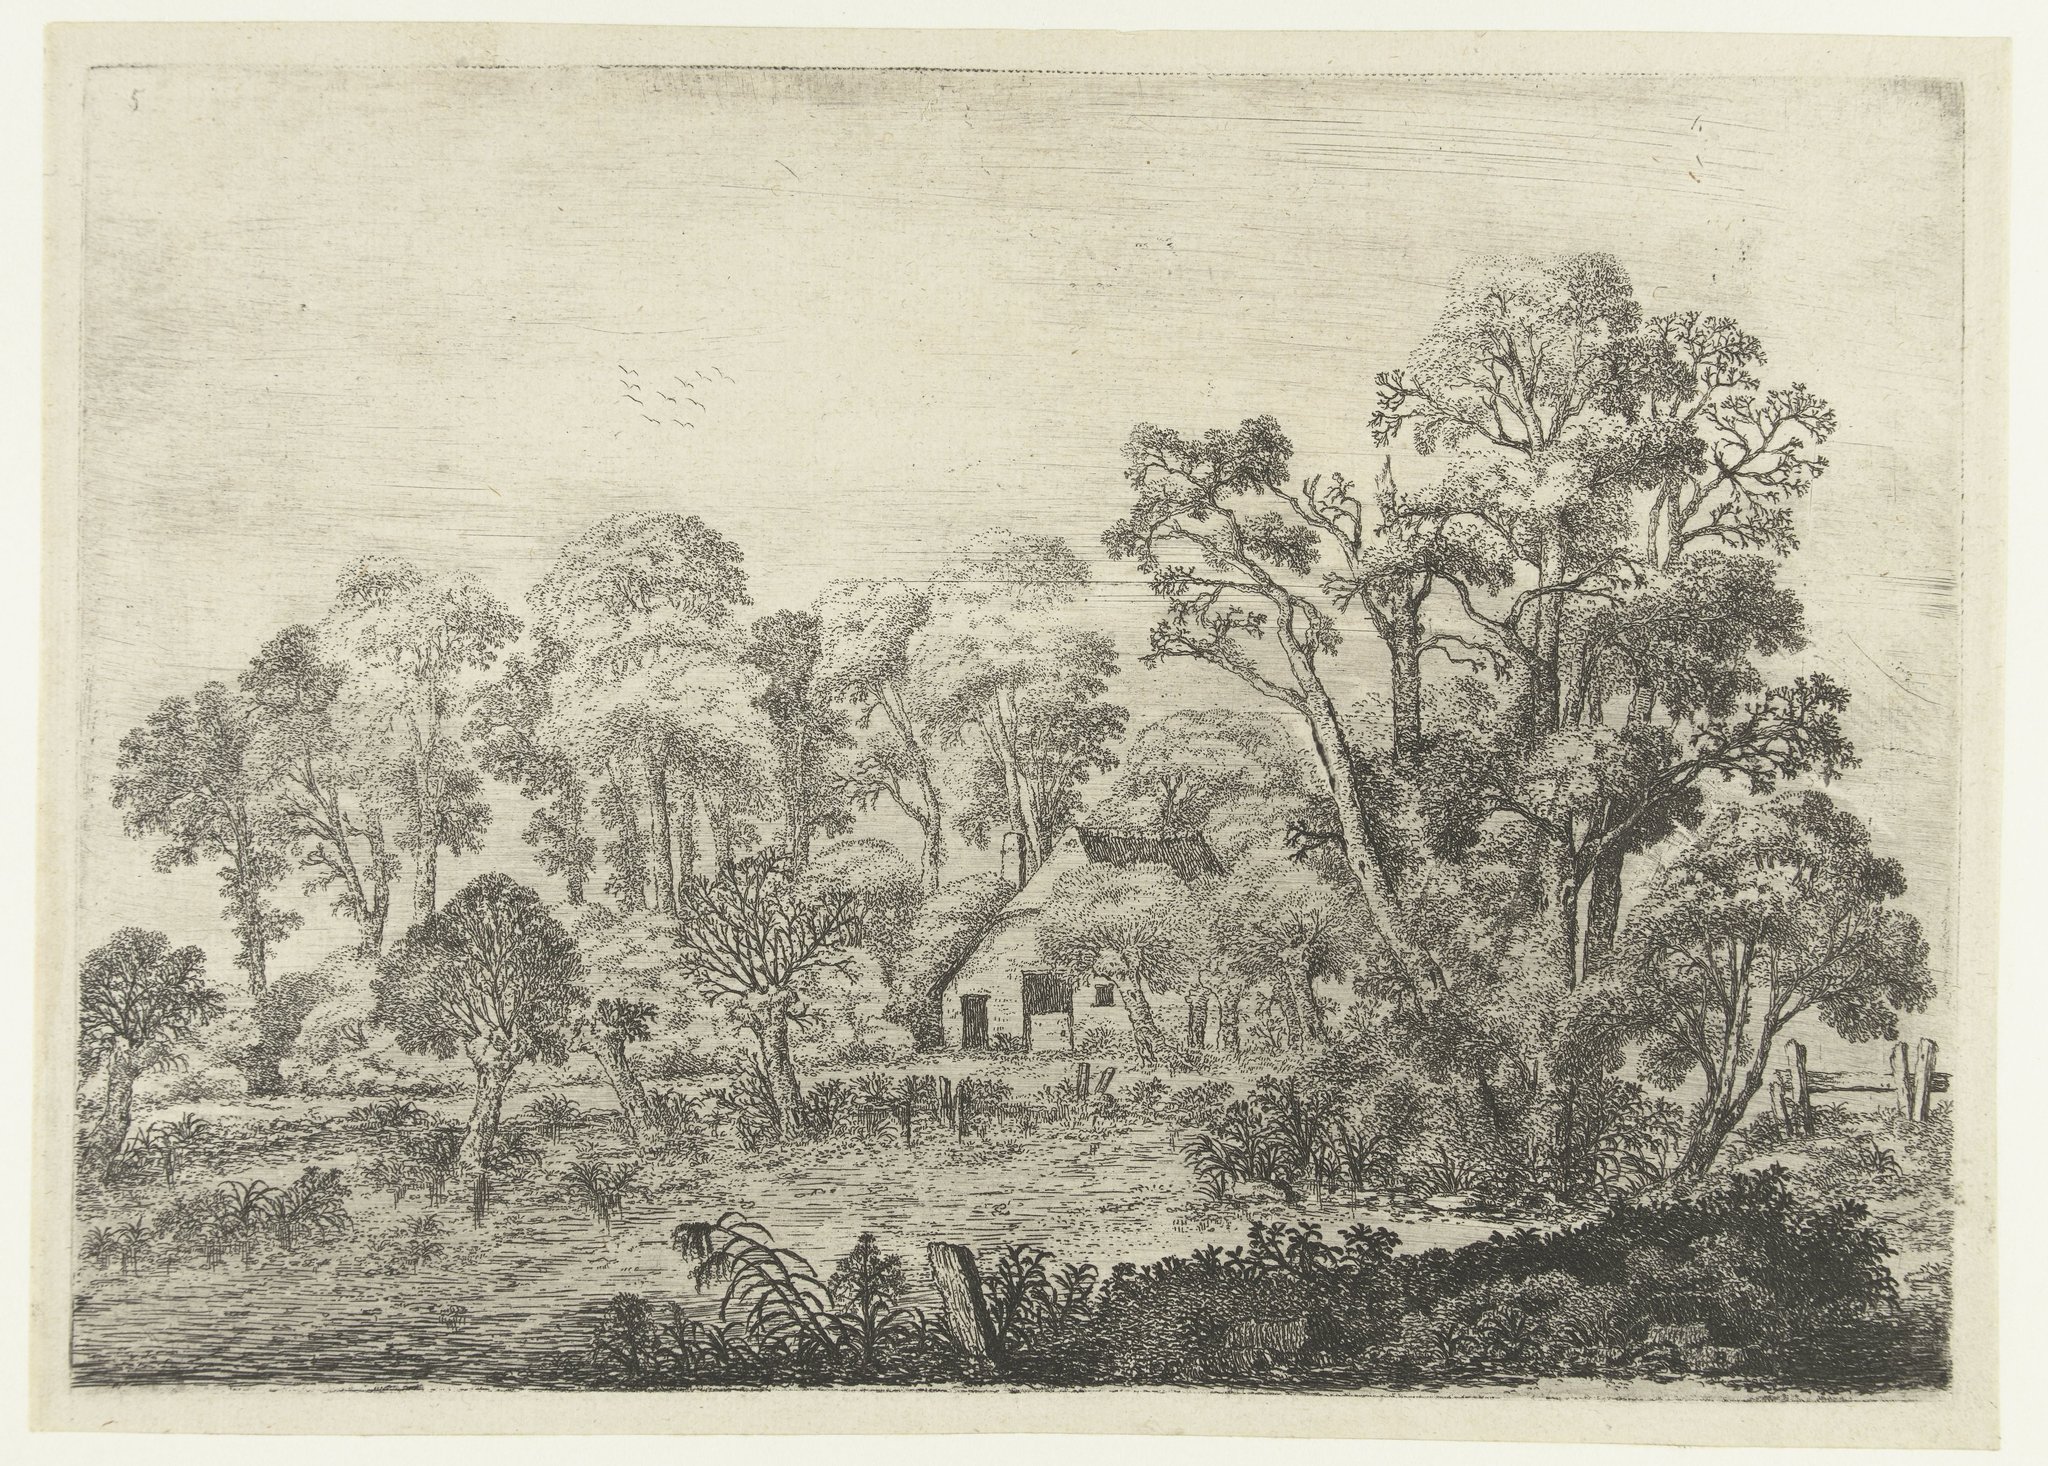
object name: print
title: Landschap met boerderij bij een vijver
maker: jan van brosterhuyzen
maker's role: draughtsman, print maker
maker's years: 1596-1650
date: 1610-1650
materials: paper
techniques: etching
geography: netherlands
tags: farm or solitary house in landscape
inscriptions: annotation: ‘W/C’ Lugt 1407